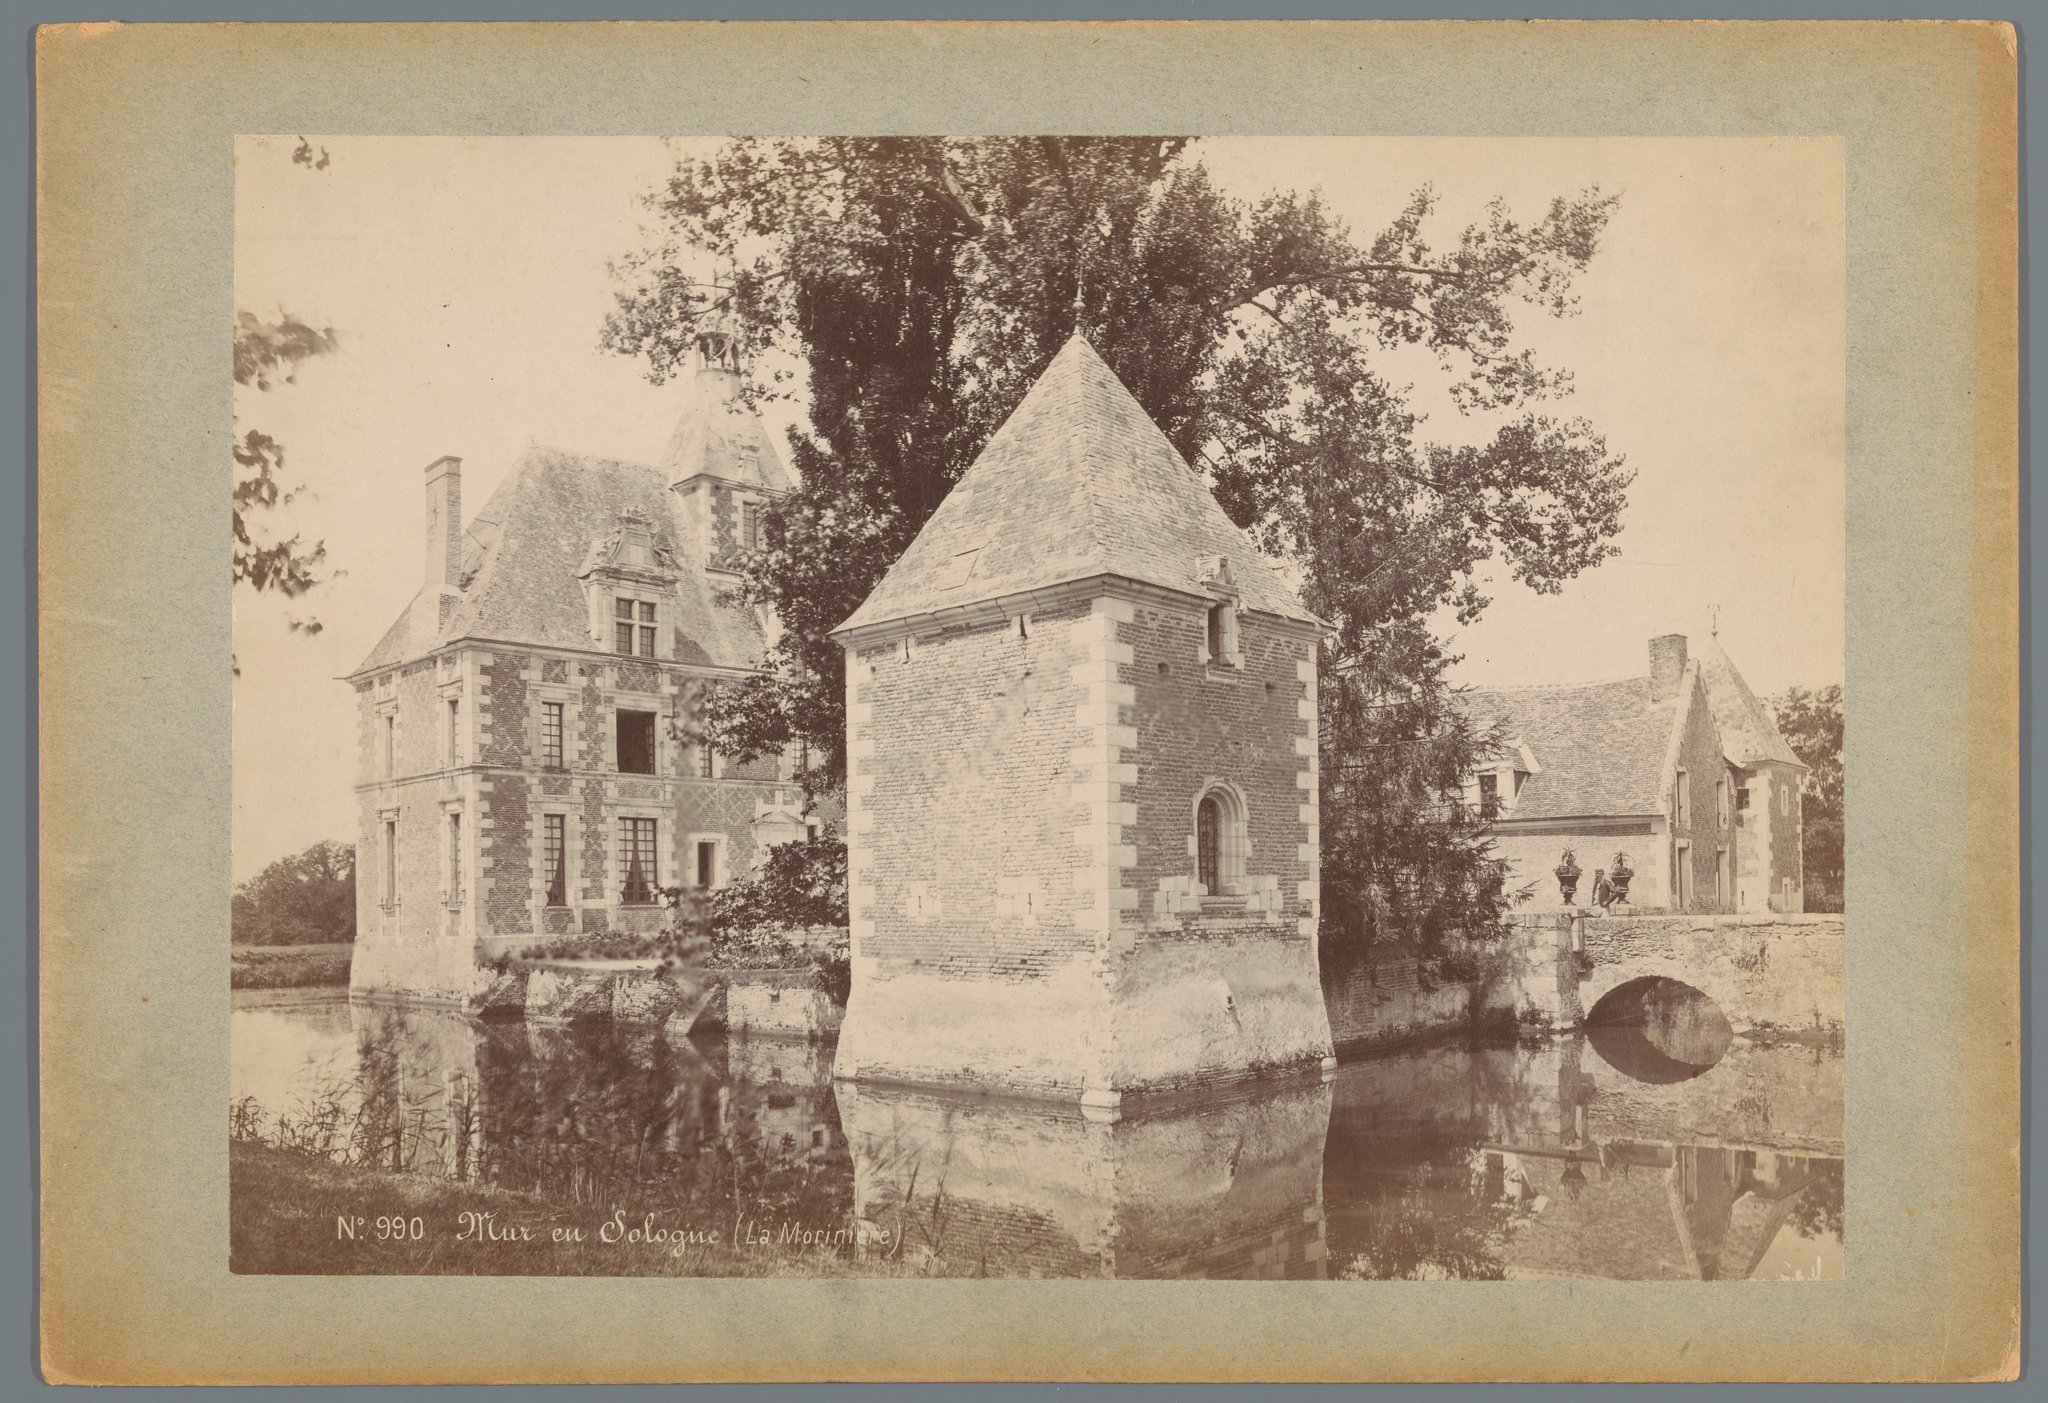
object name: photograph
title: Mur en Sologne (La Morinière)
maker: séraphin-médéric mieusement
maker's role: fotograaf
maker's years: 1840-1905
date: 1875-1900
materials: cardboard, photographic support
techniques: albumen print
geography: loir-et-cher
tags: tower, clock tower ~ monumental adornment, castle, river, bridge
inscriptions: name: ‘KUNSTBOEKHANDEL J. A. G. DE LEUR PHOTOGRAAF - UITGEVER Huigenspark, 40b. DEN HAAG’, name: ‘MIEUSEMENT PHOTOGRAPHE’, inscription: ‘Stijlkast pl. 12 - 13’, number: ‘No. 990’, collector's mark: Lugt 3937, name: ‘MONUMENTS HISTORIQUES’